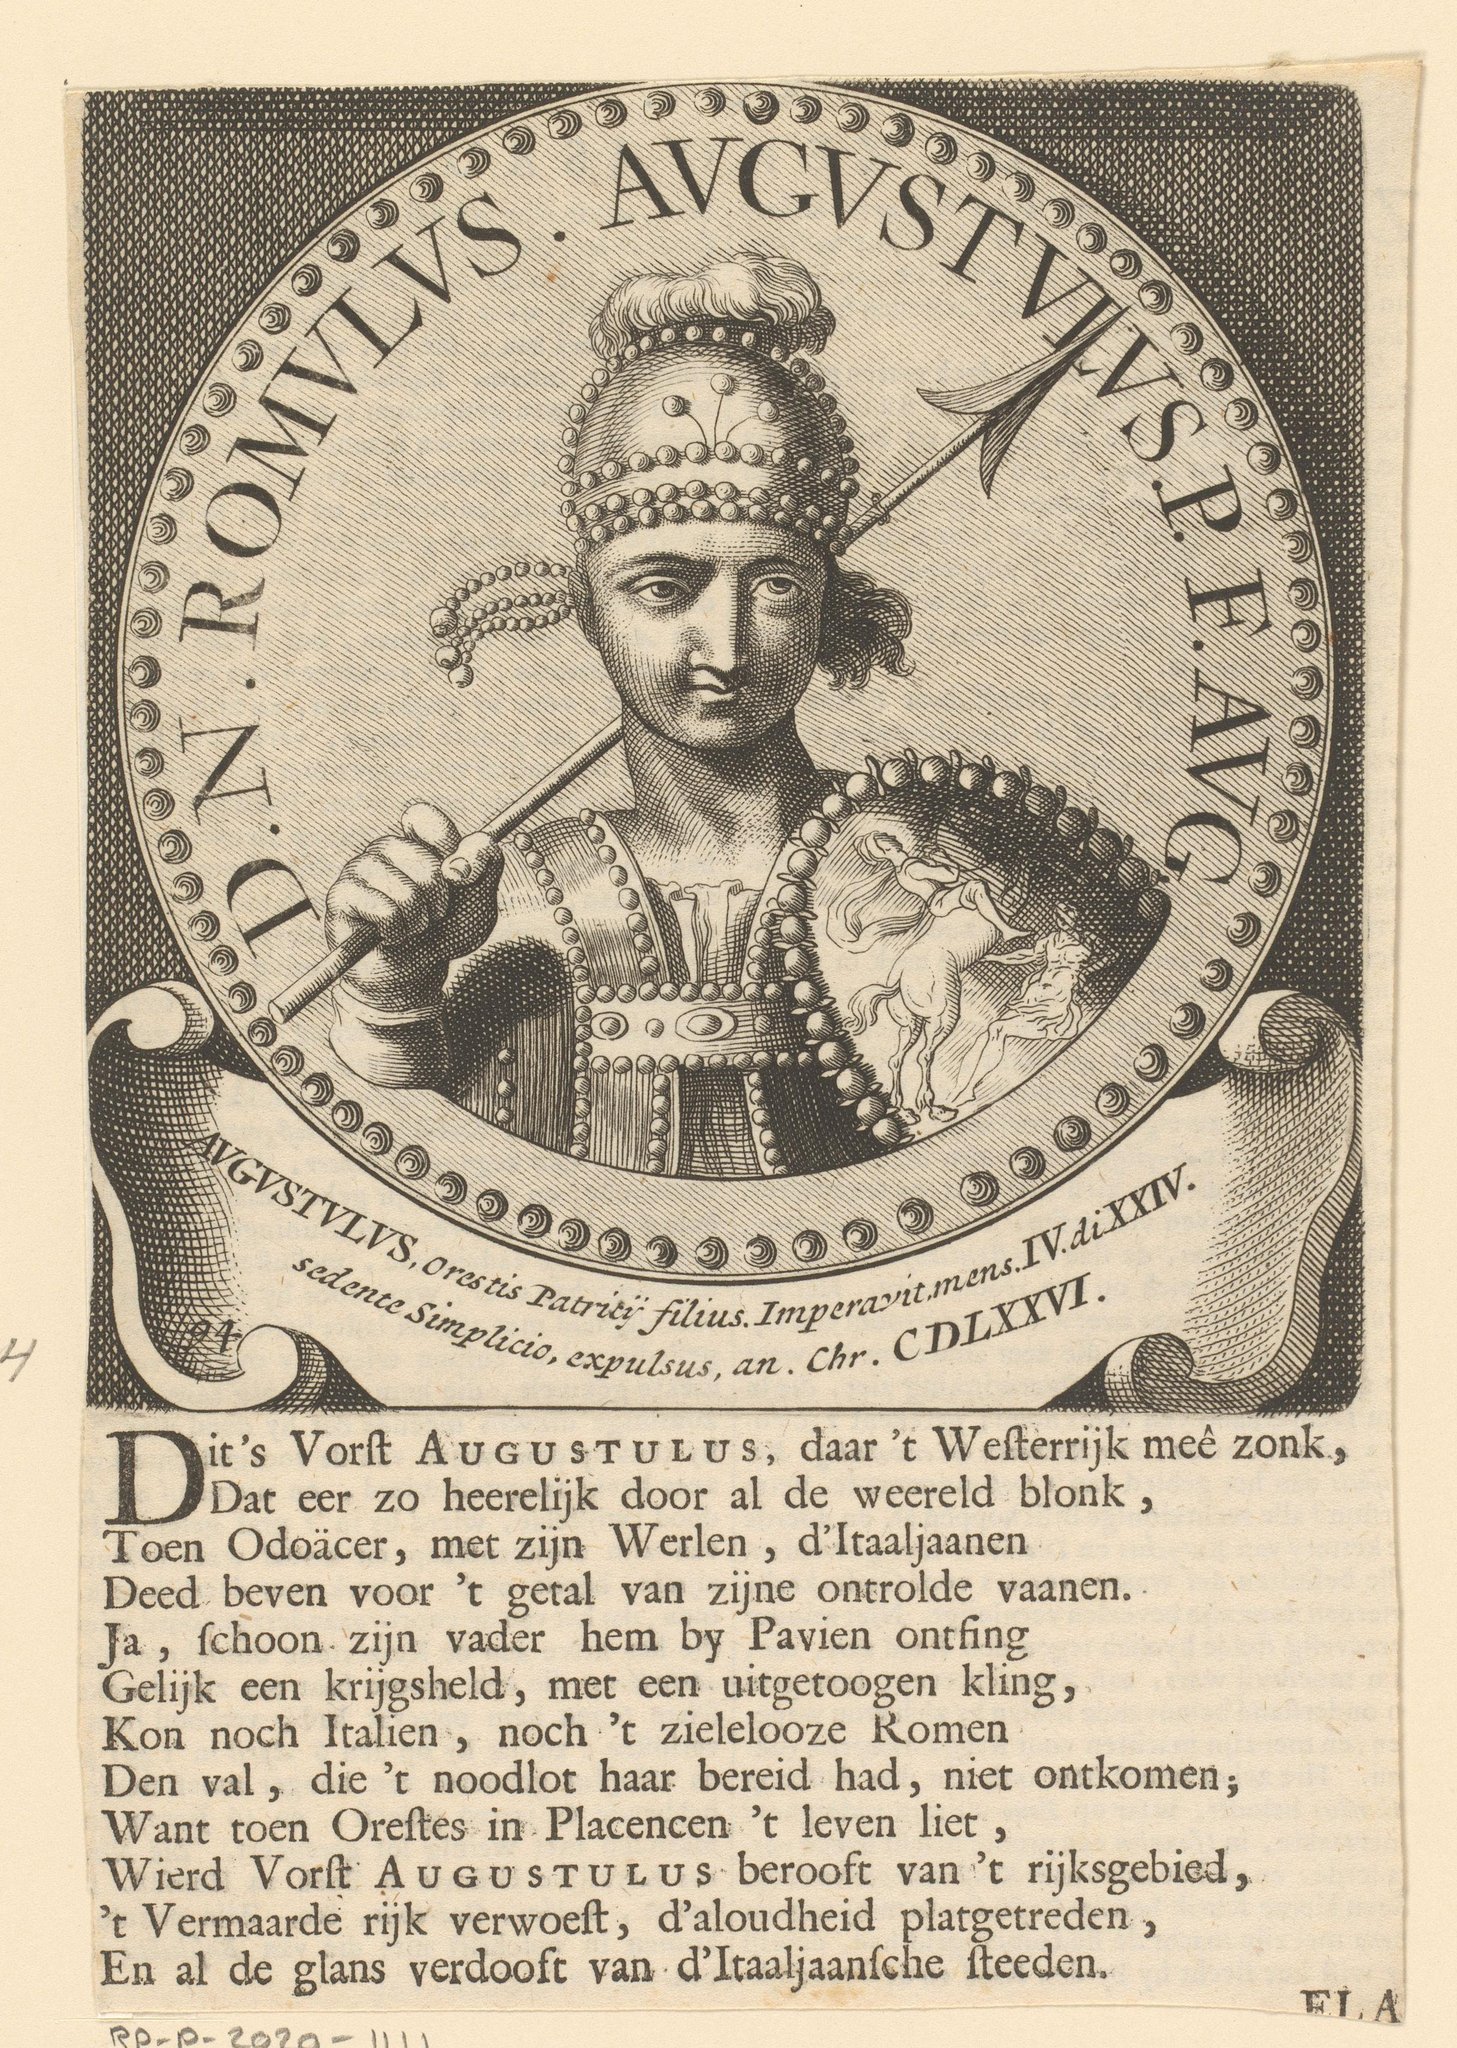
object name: book illustration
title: Augustulus, Orestis patricii filius (...)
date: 1697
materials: paper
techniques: engraving, etching, letterpress printing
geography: utrecht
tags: historical persons, emperor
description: Prent uit: Bogaert, Abraham. De Roomsche monarchy, vertoont in de muntbeelden der westersche en oostersche keizeren (...). Utrecht: François Halma en Willem van de Water, 1697, p. 295. Eerste staat verschenen in een grotere prent met twaalf portretten, gedateerd 1695.